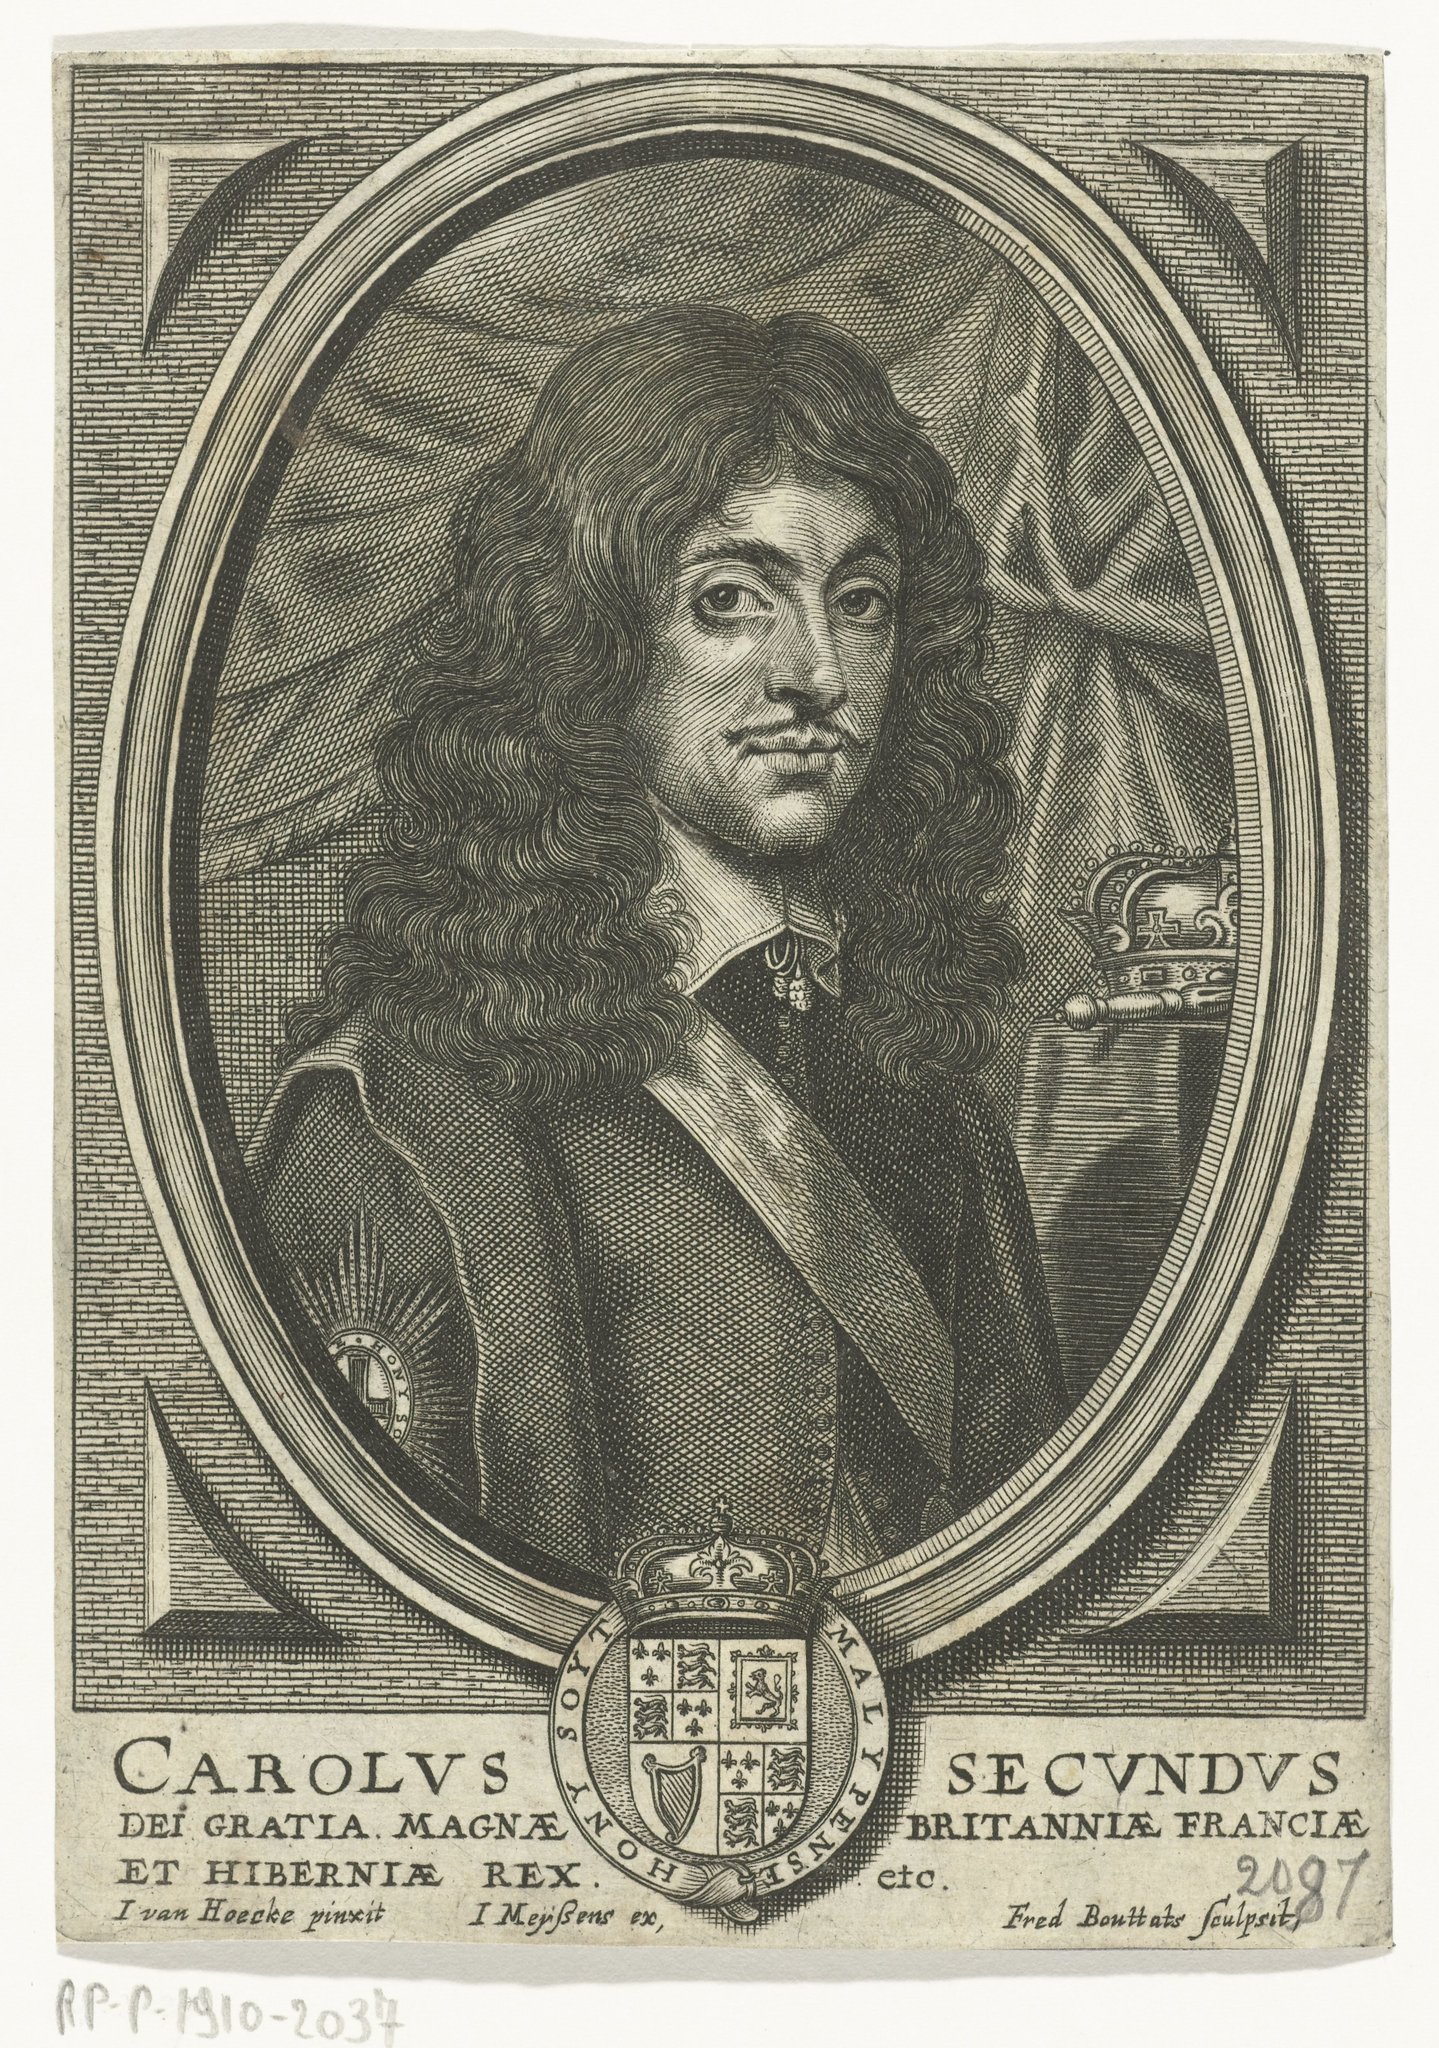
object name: print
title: Portret van Karel II van Engeland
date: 1649-1676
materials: paper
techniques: engraving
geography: antwerp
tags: london, karel ii (koning van engeland)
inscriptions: collector's mark: Lugt 2228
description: Portret in ovale lijst van Karel II van Engeland. Buste naar rechts. Naast Karel II liggen de regalia kroon en scepter. Onder het portret een Latijns onderschrift.